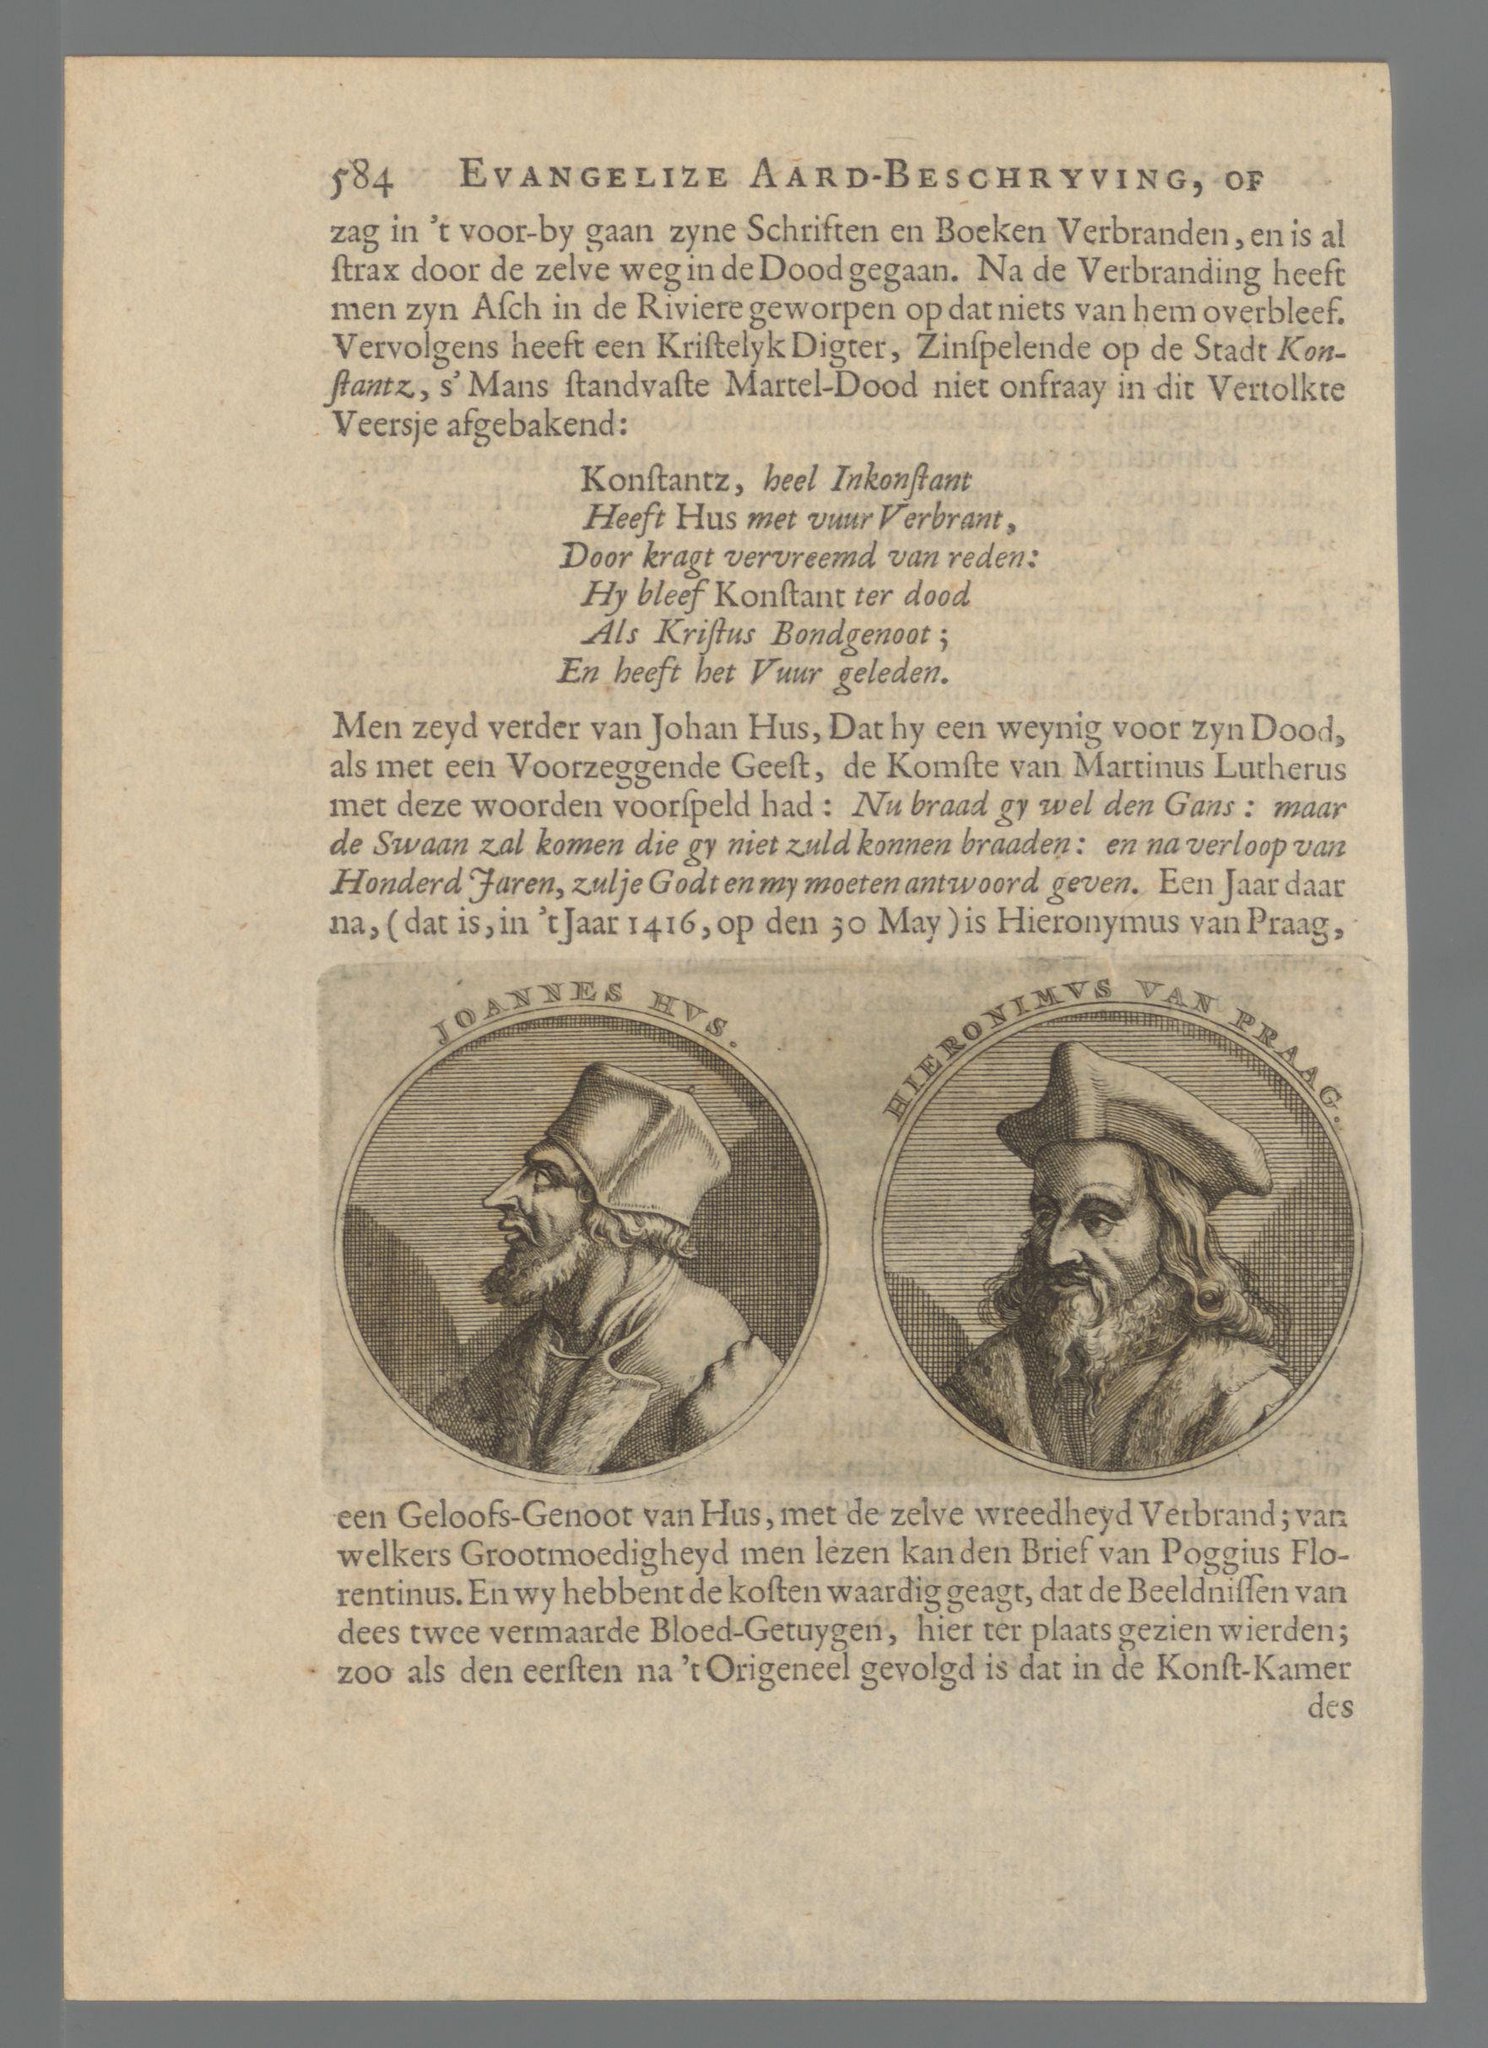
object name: print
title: Portretten van Johannes Hus en Hiëronymus van Praag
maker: Anonymous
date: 1705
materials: paper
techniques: etching, letterpress printing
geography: amsterdam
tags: prague, adult man, historical persons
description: Prent uit: Goeree, Wilhelmus. De kerklyke en weereldlyke historien; uyt d'aal-ouwde aardbeschryving, en uytgezogte gedenk-penningen opgehelderd (...). Amsterdam: Gerardus en Jacobus Borstius, 1705.